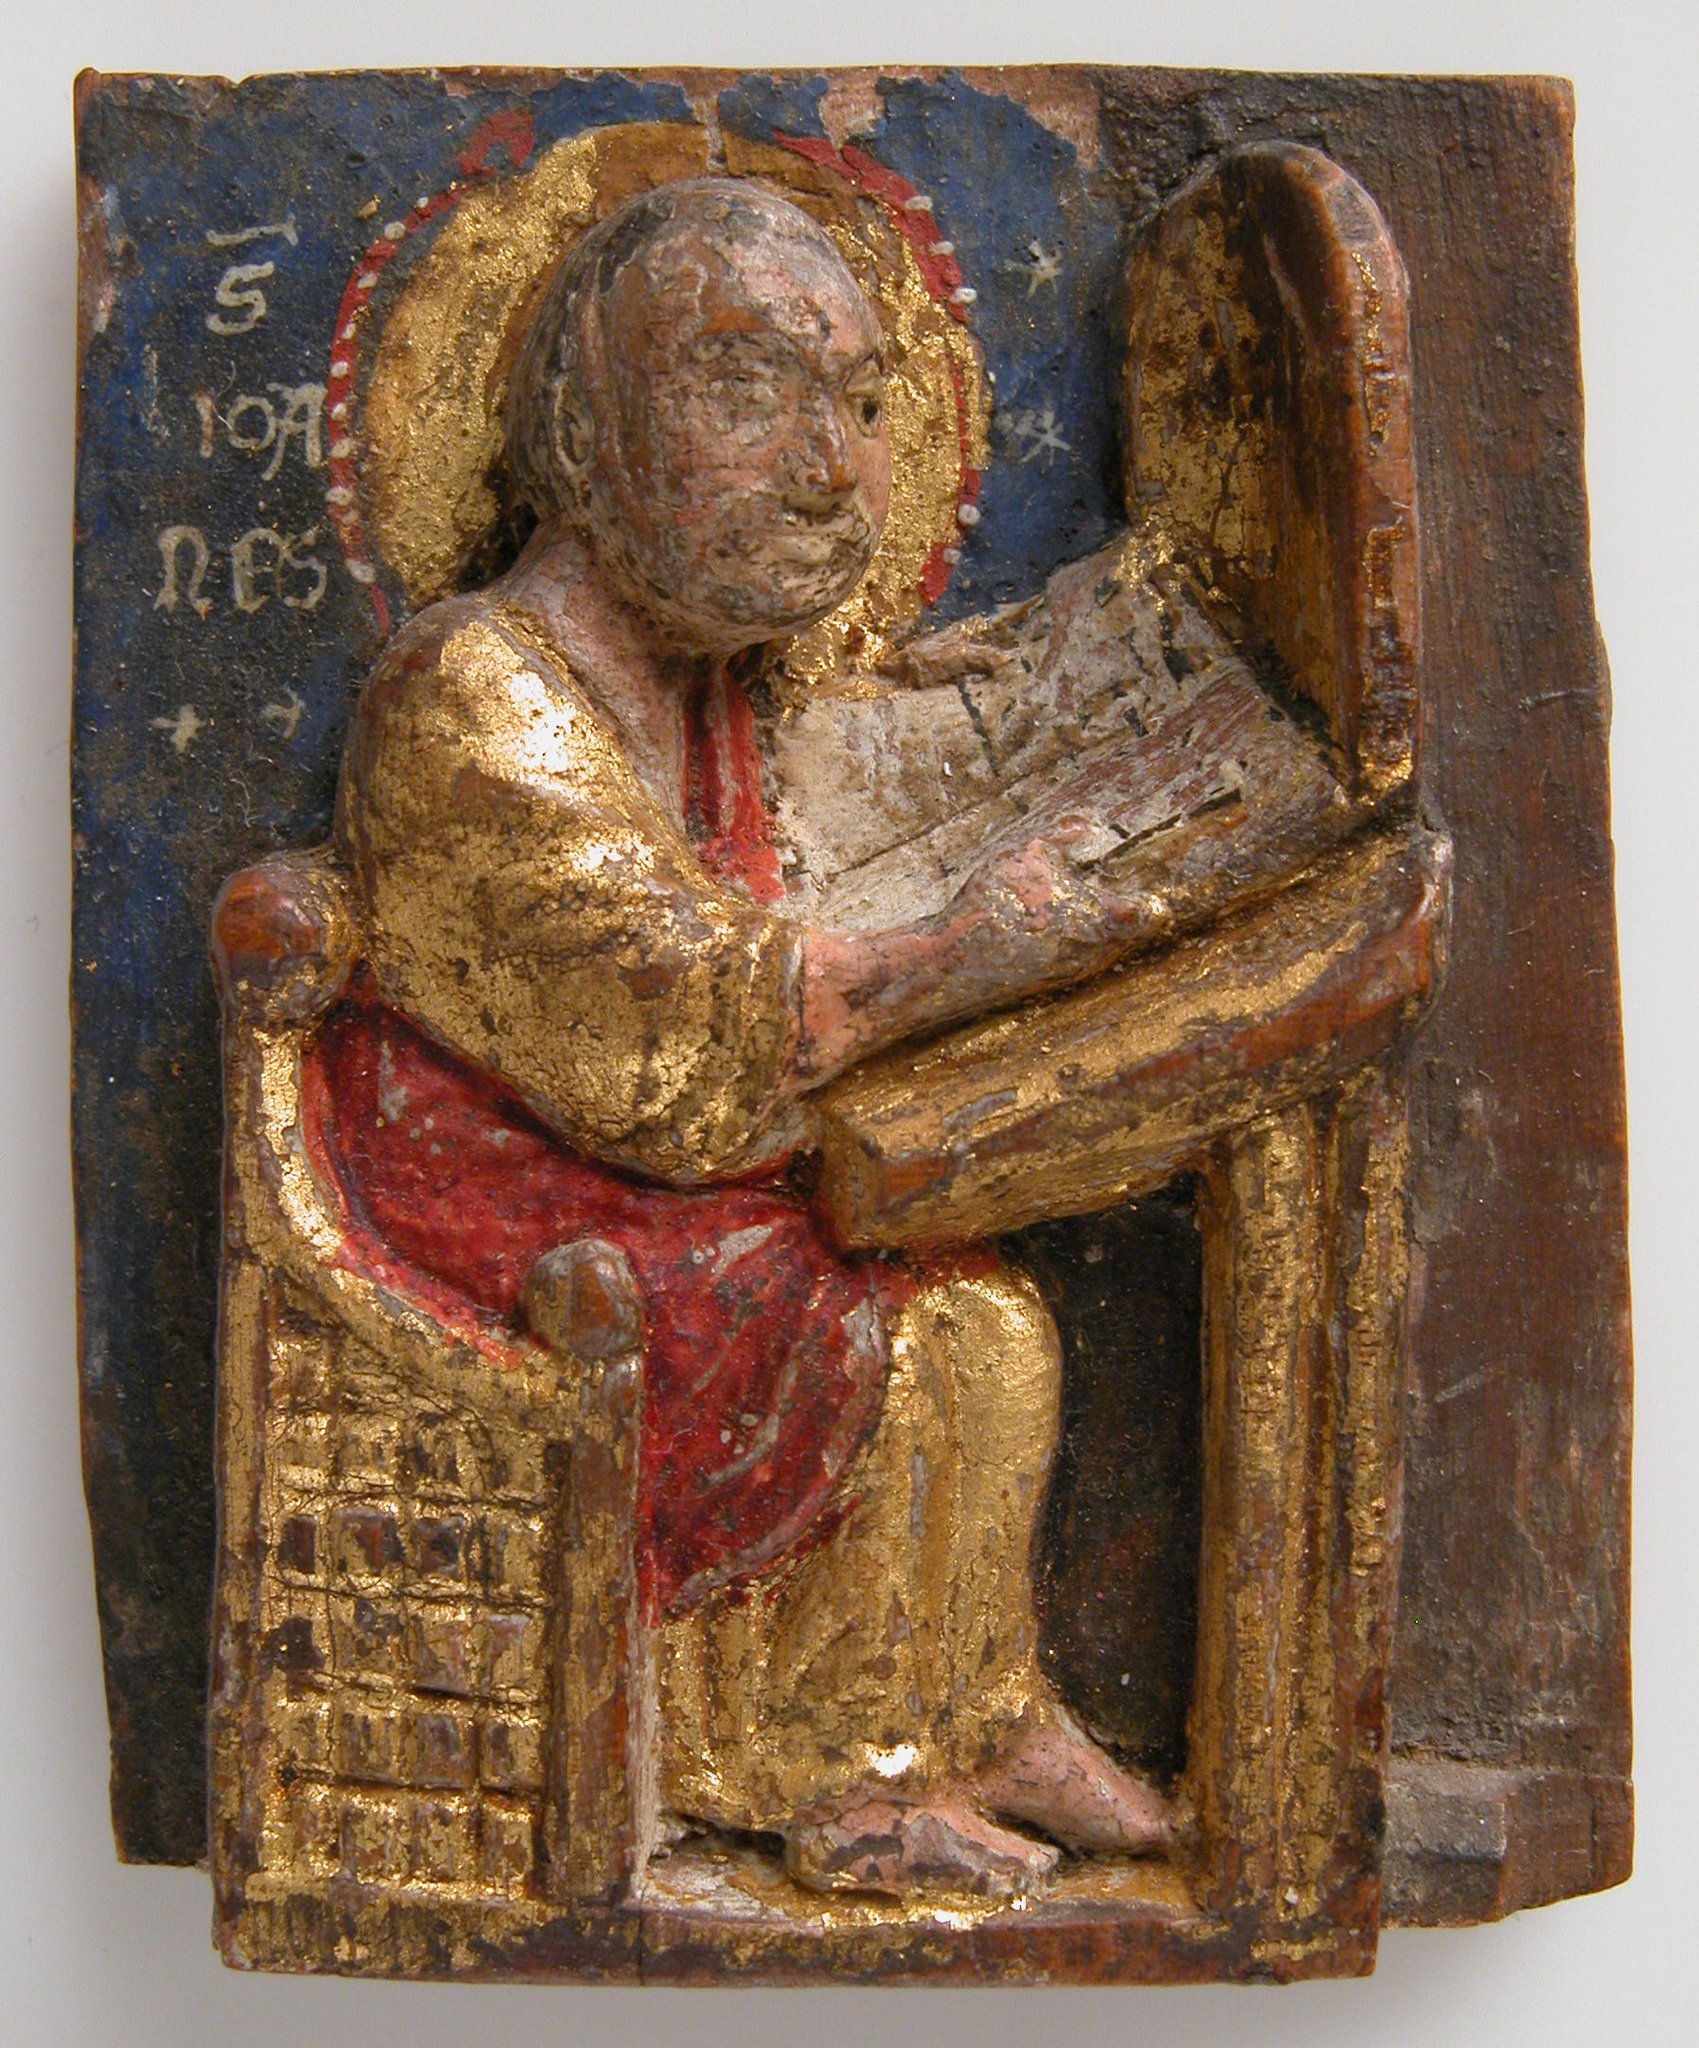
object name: relief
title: Miniature Relief of Saint John the Evangelist at His Writing Table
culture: german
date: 1200-1225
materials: wood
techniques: gilding, polychromy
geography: germany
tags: reading